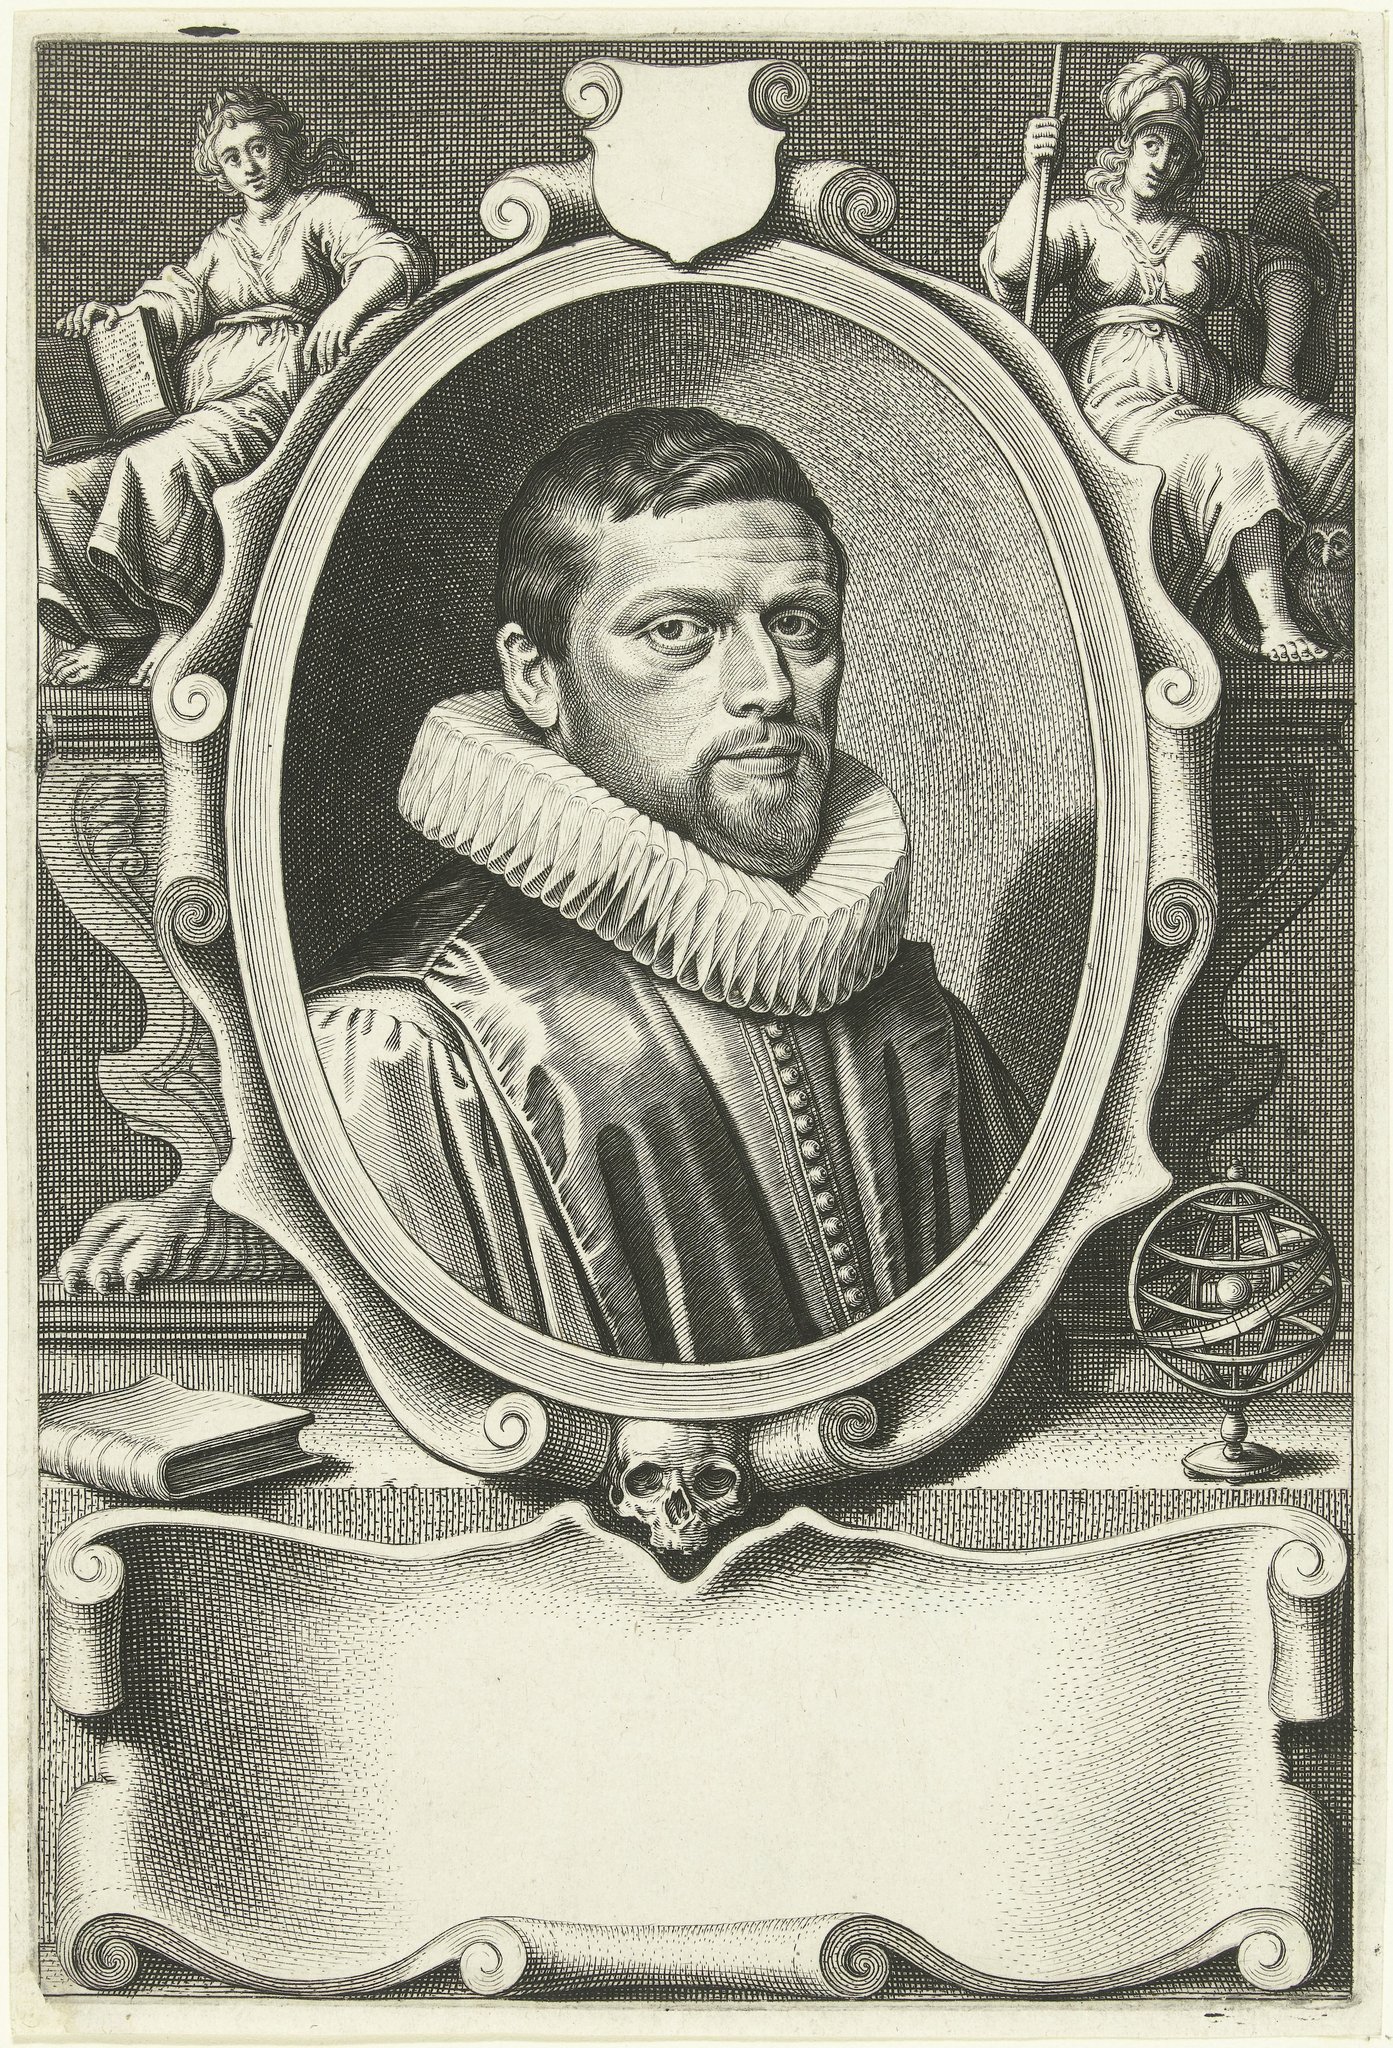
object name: print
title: Portret van Caspar van Baerle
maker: willem jacobsz delff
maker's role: draughtsman, print maker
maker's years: 1580-1638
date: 1625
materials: paper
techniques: engraving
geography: delft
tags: antwerp, amsterdam, caspar van baerle, minerva as patroness, scholar, philosopher, writer, poet, author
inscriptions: collector's mark: Lugt 2229, inscription: Lugt 963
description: Portret van Caspar van Baerle, borststuk, gekleed in toga en molenkraag in ovale omlijsting met rolwerk bekroond met leeg wapenschild. Minerva en mogelijk personificatie van de Poëzie flankeren het portret. Onder leeg cartouche.